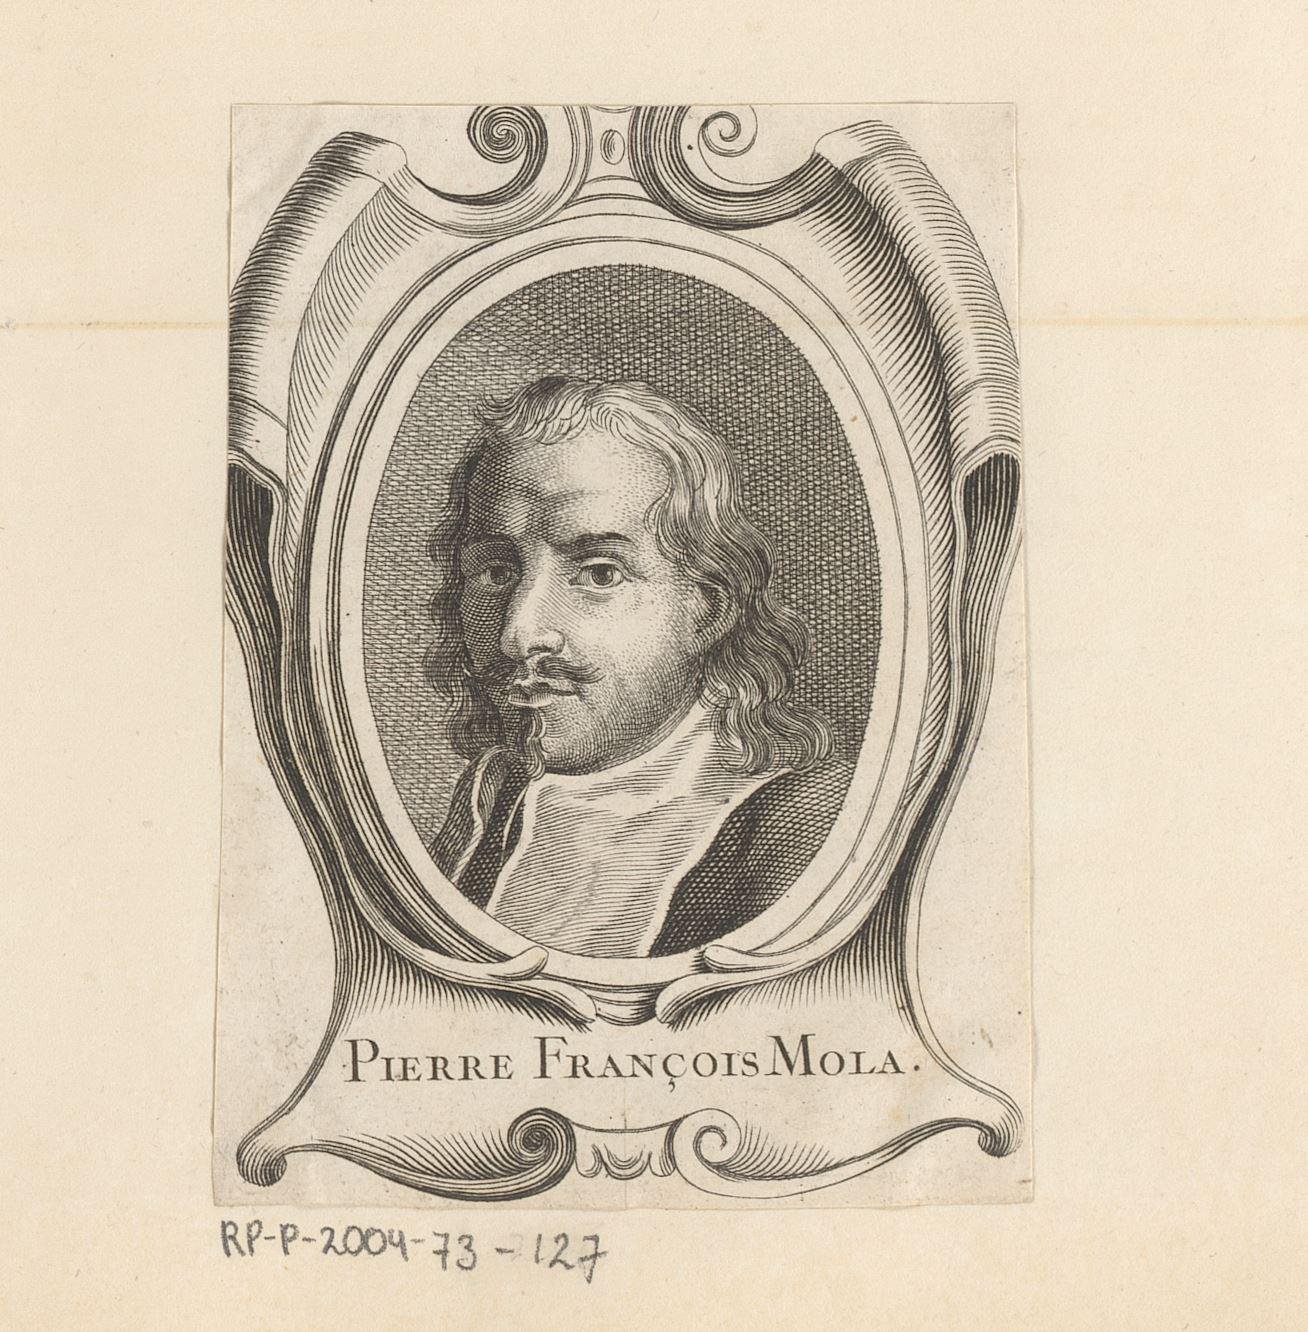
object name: book illustration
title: Pierre François Mola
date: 1745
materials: paper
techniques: engraving, letterpress printing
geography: paris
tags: rome, print maker, draughtsman, pier francesco mola, historical persons, portrait, self-portrait of painter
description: Prent uit: Dézallier d'Argenville, Antoine Joseph. Abrégé de la vie des plus fameux peintres. 4 dln. Parijs: De Bure l'aîné, 1745, dl. 1, p. 313. De samensteller heeft deze prent in het album geplakt als illustratie bij: Pilkington, Matthew en Johann Heinrich Füssli. A dictionary of painters, from the revival of the art to the present period. 4 dln. Londen: John Crowder, 1805, dl. 2, p. 342.